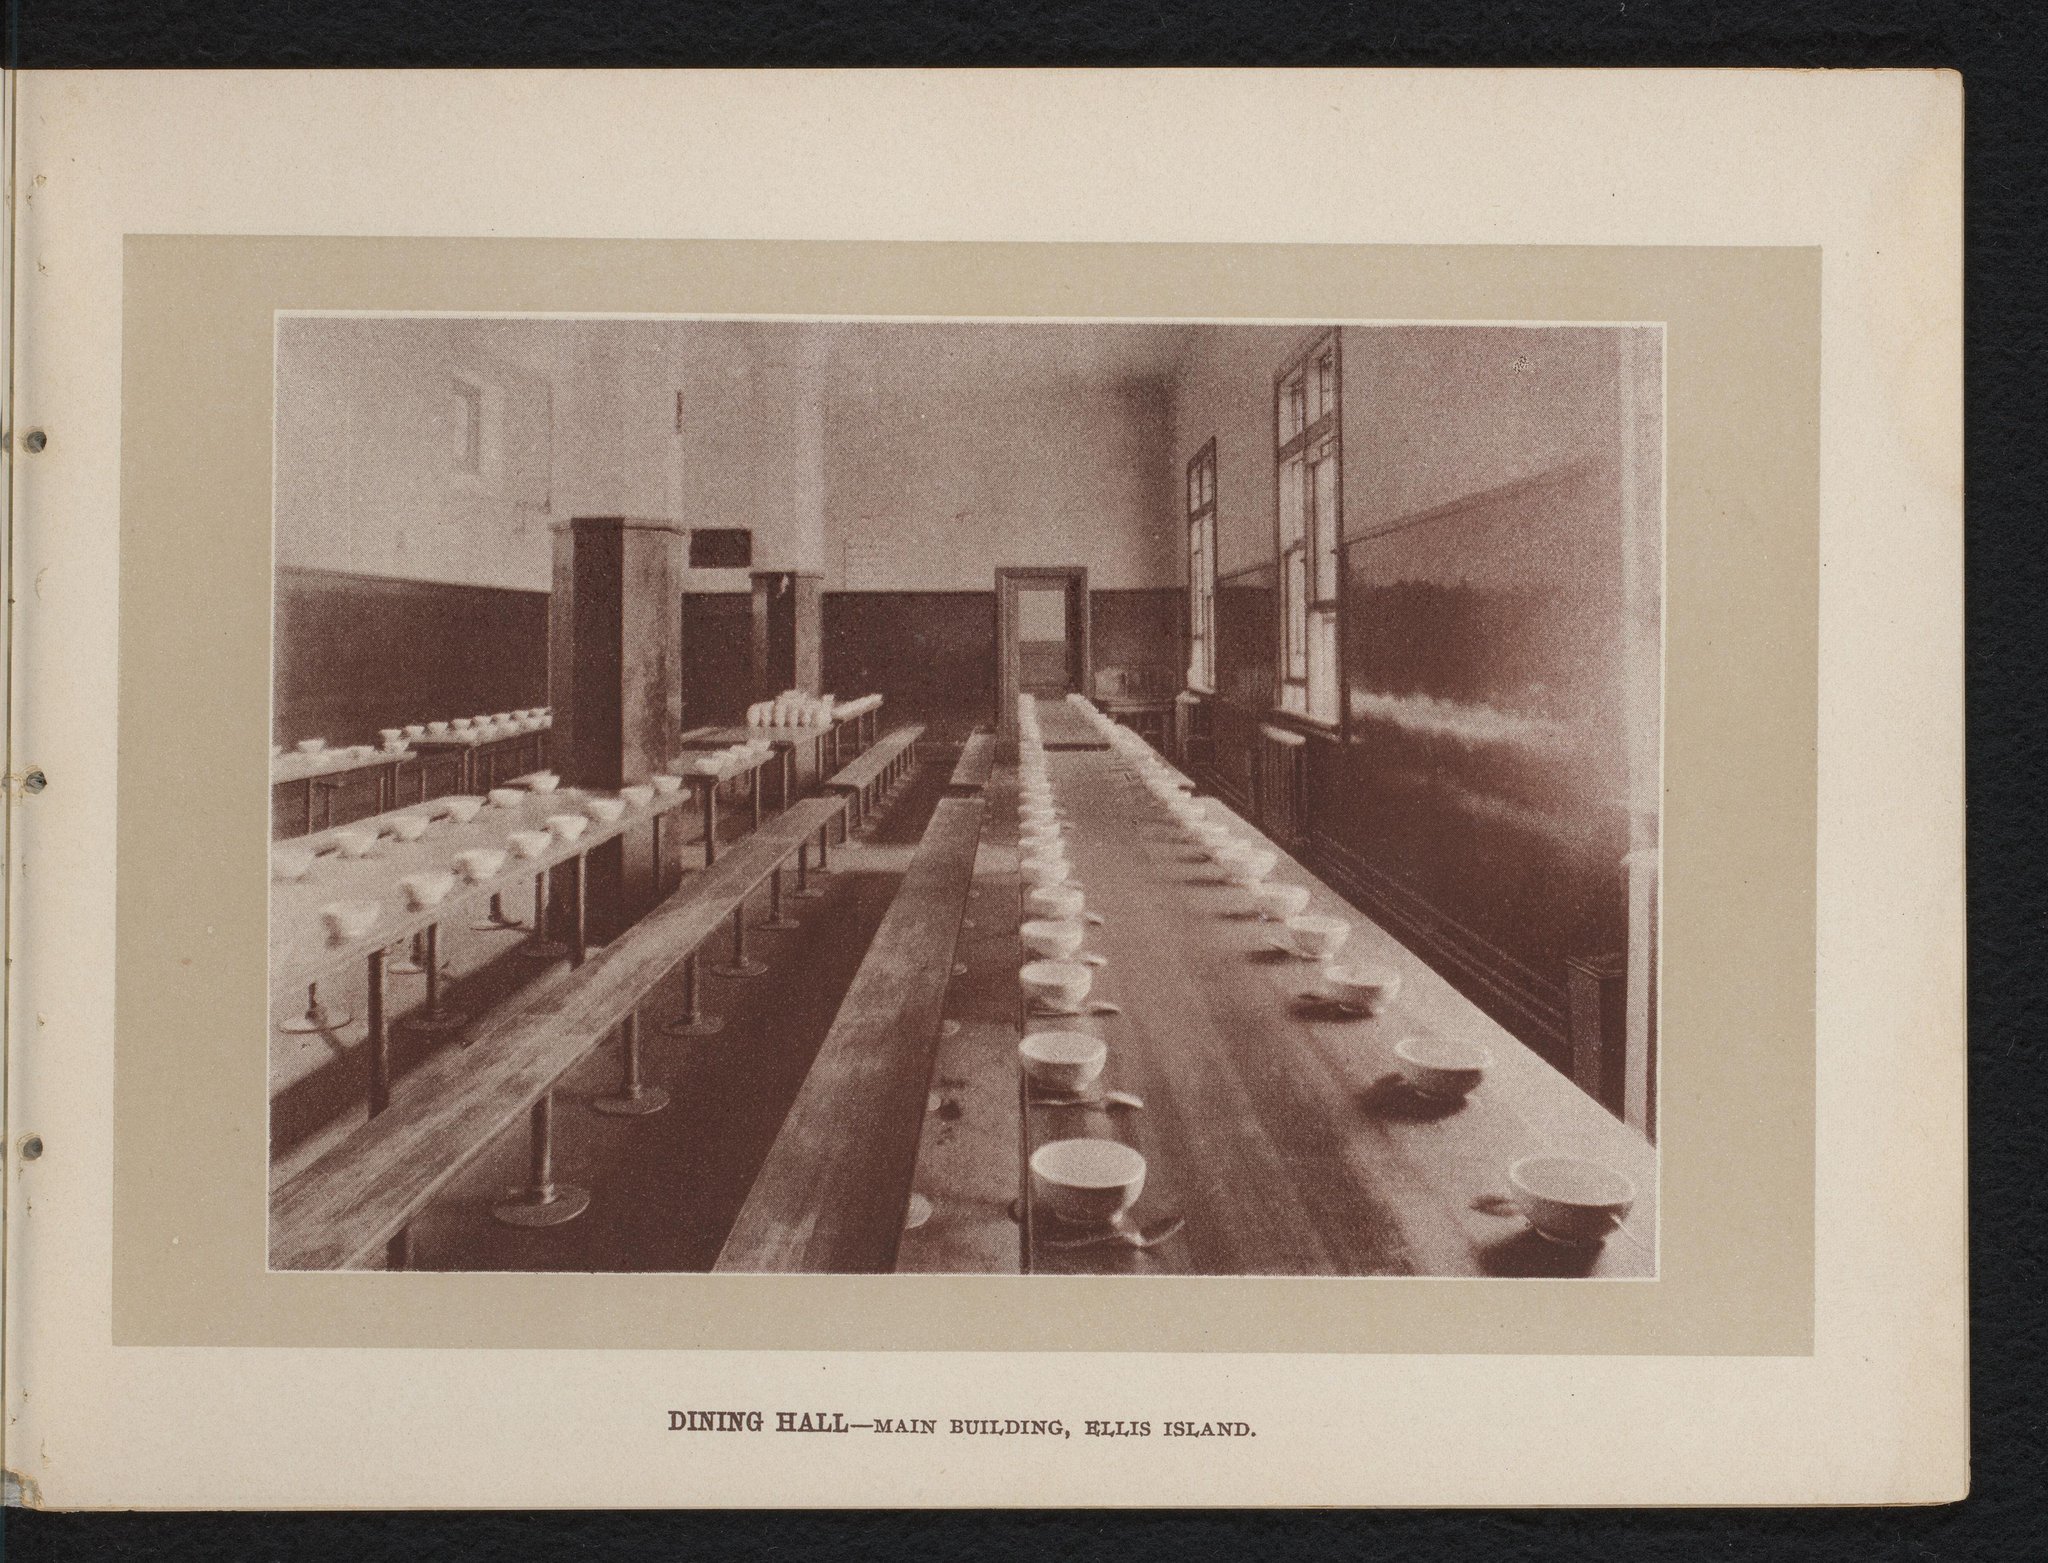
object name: photomechanical print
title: Dining hall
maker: Anonymous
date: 1897-1902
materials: paper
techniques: autotype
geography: new york city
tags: institution for contagious diseases, (descendants of) european emigrants to america, dining-room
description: Prent op twintigste ongenummerde pagina.